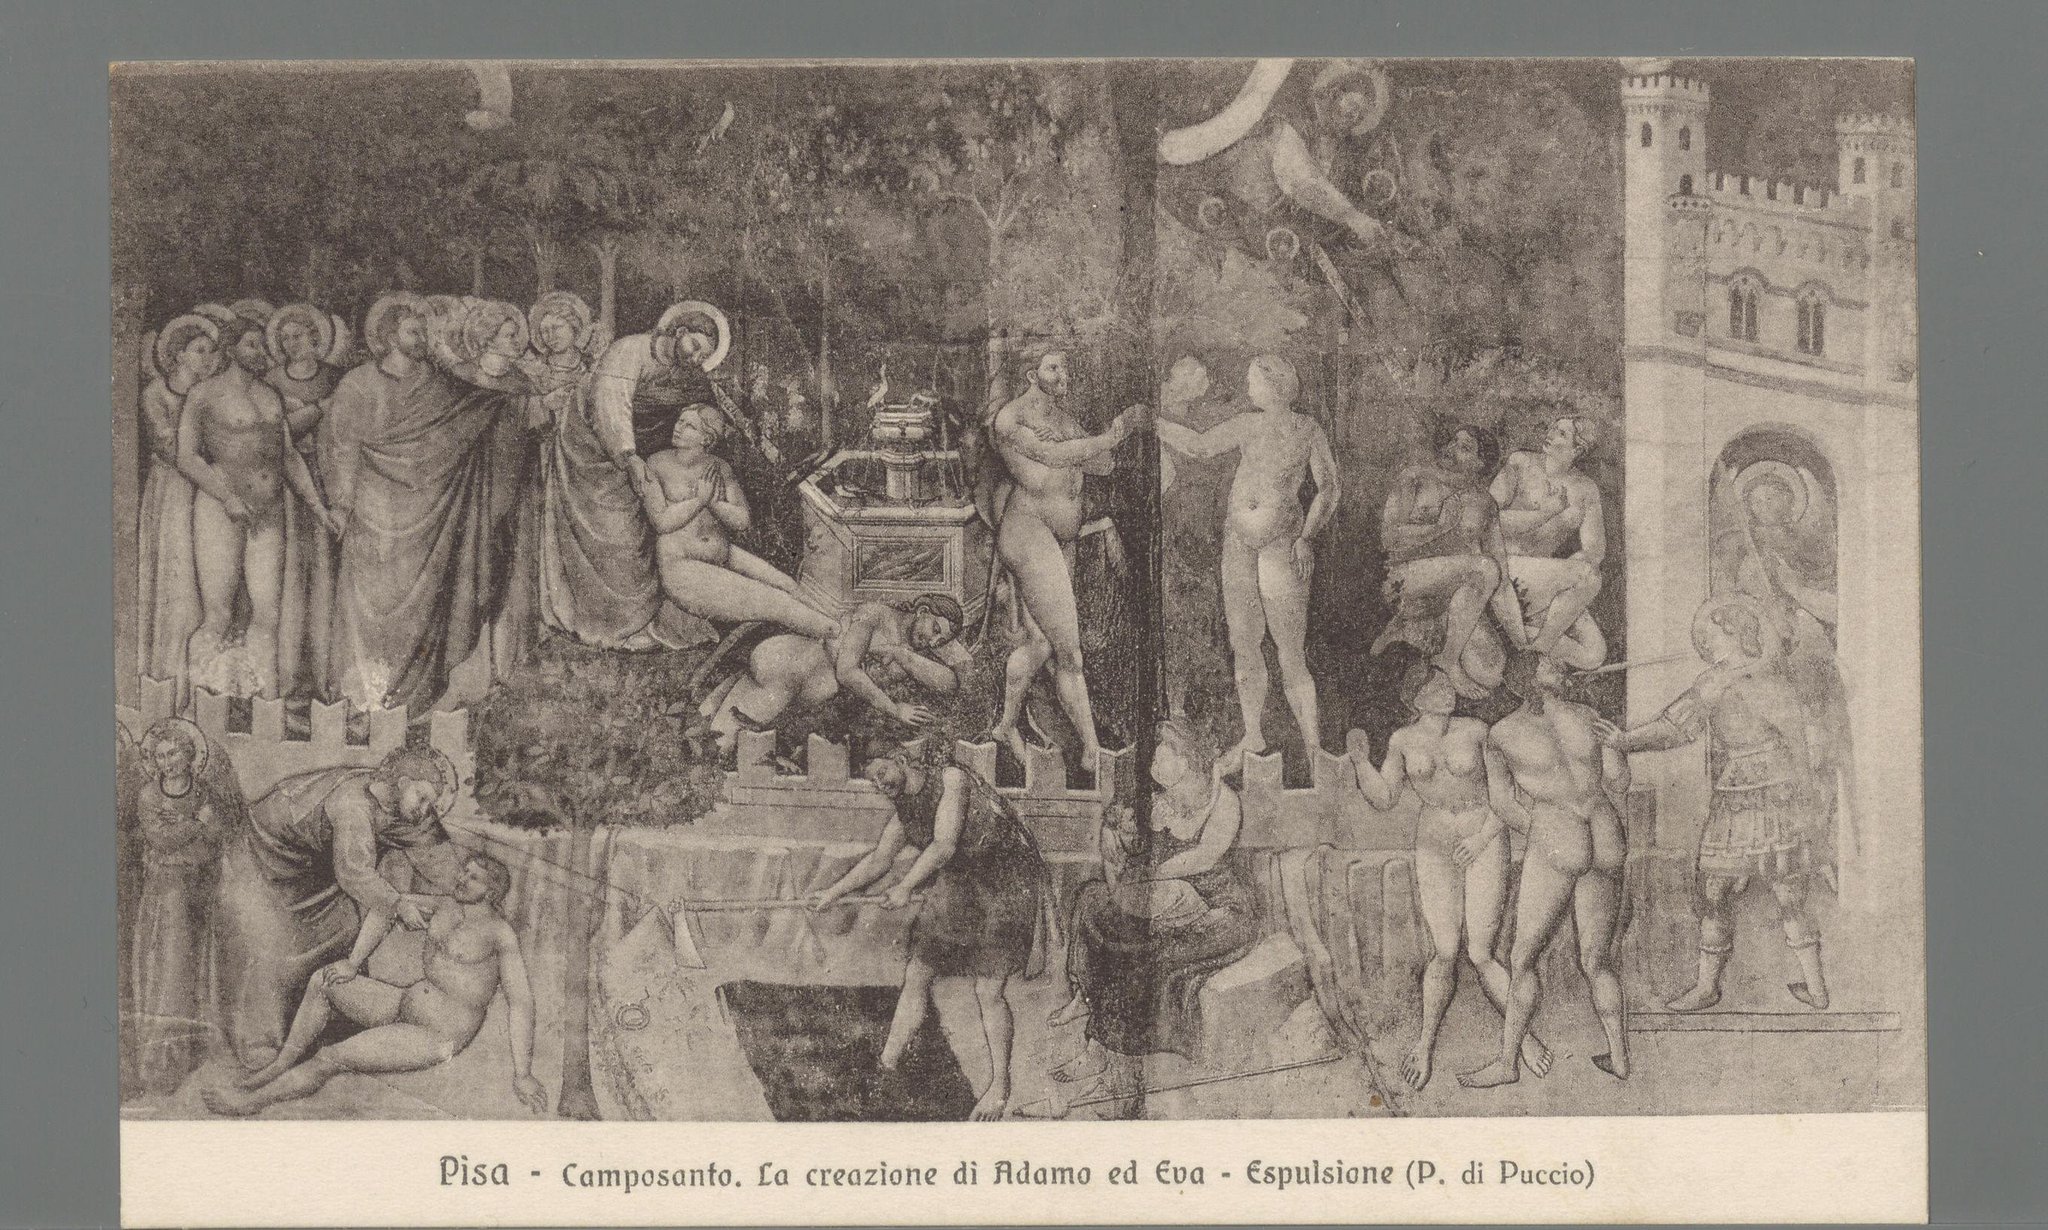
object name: reproduction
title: Pisa - Camposanto. La creazione di Adamo ed Eva - Espulsione (P. di Puccio)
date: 1906-1930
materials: cardboard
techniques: photograph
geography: pisa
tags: picture, painting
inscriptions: collector's mark: ‘AFE v S’